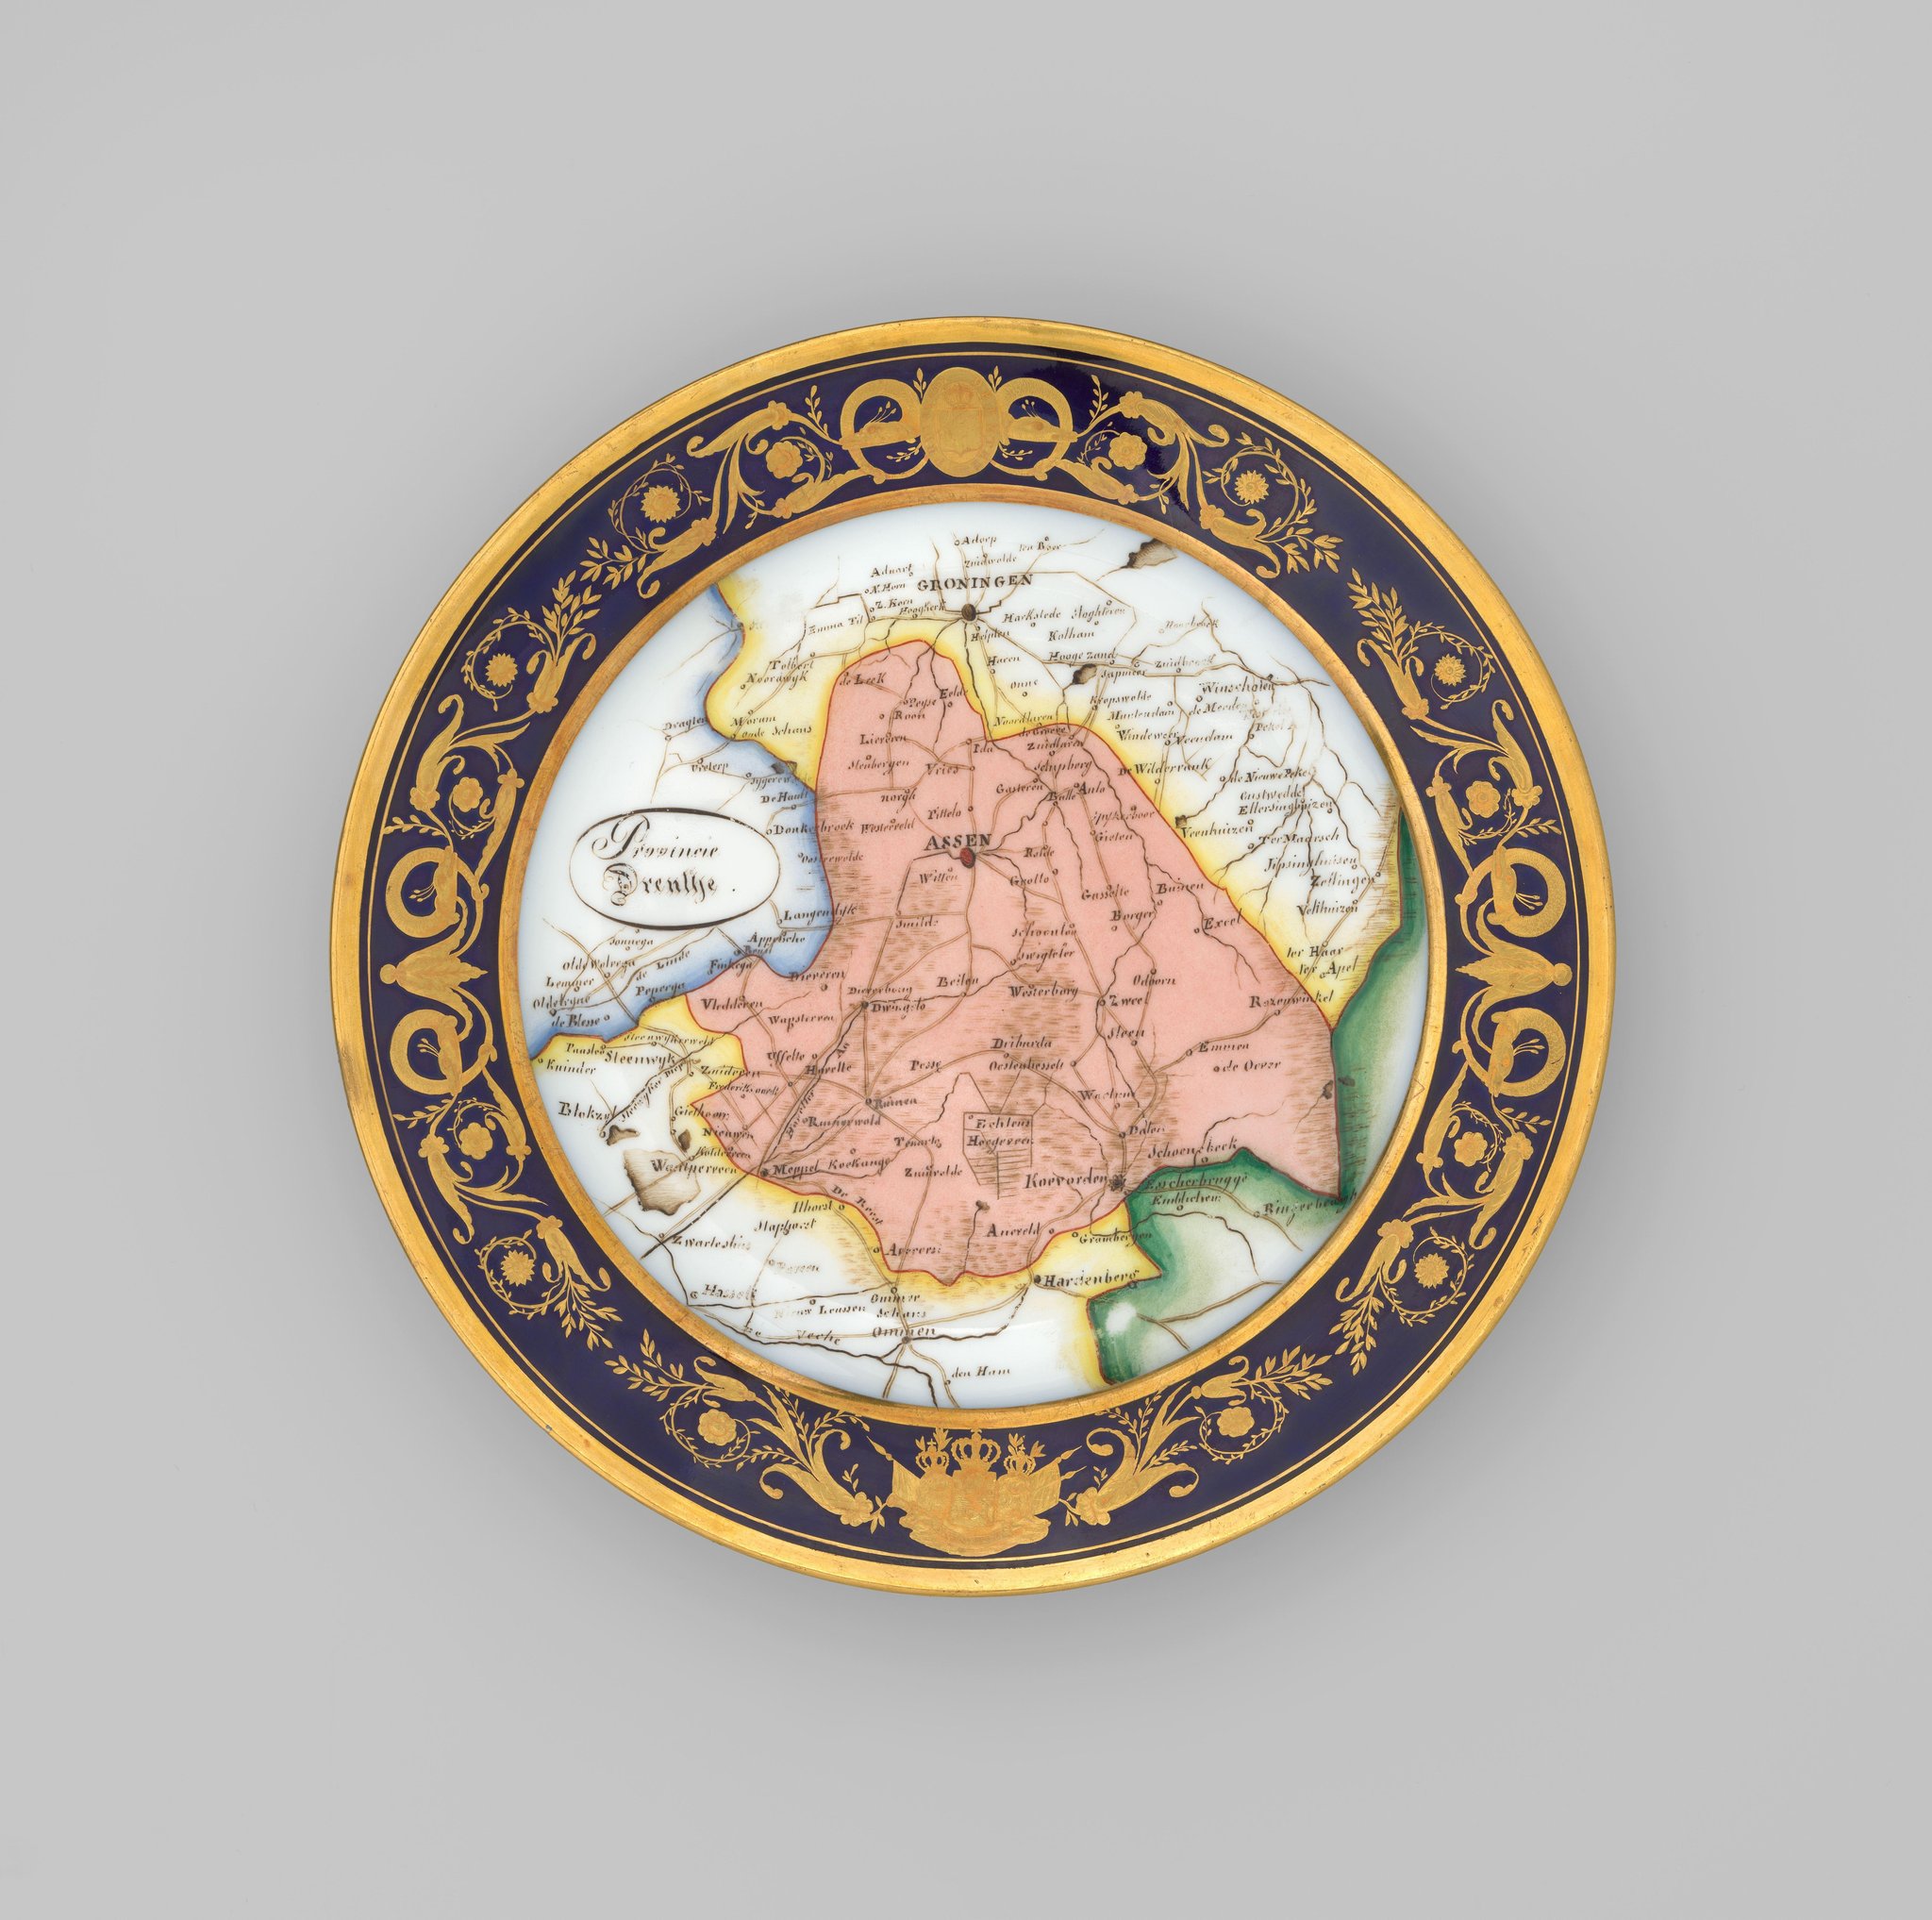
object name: plate dish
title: 18 plates, each decorated with a Netherlandish province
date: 1822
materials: glaze, gold, paint, porcelain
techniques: firing, gilding, turning, vitrification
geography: paris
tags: drenthe, verenigd koninkrijk der nederlanden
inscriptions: monogram and date: ‘R. D. 1822’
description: These plates reflect the period when the Netherlands and Belgium together formed the United Kingdom of the Netherlands (1815-1830). The kingdom consisted of 17 provinces plus the grand duchy of Luxembourg. The gold decoration is in the Neoclassical style. On the upper edge are the arms of the kingdom, on the lower border those of each province. Today the Netherlands consists of 12 provinces.